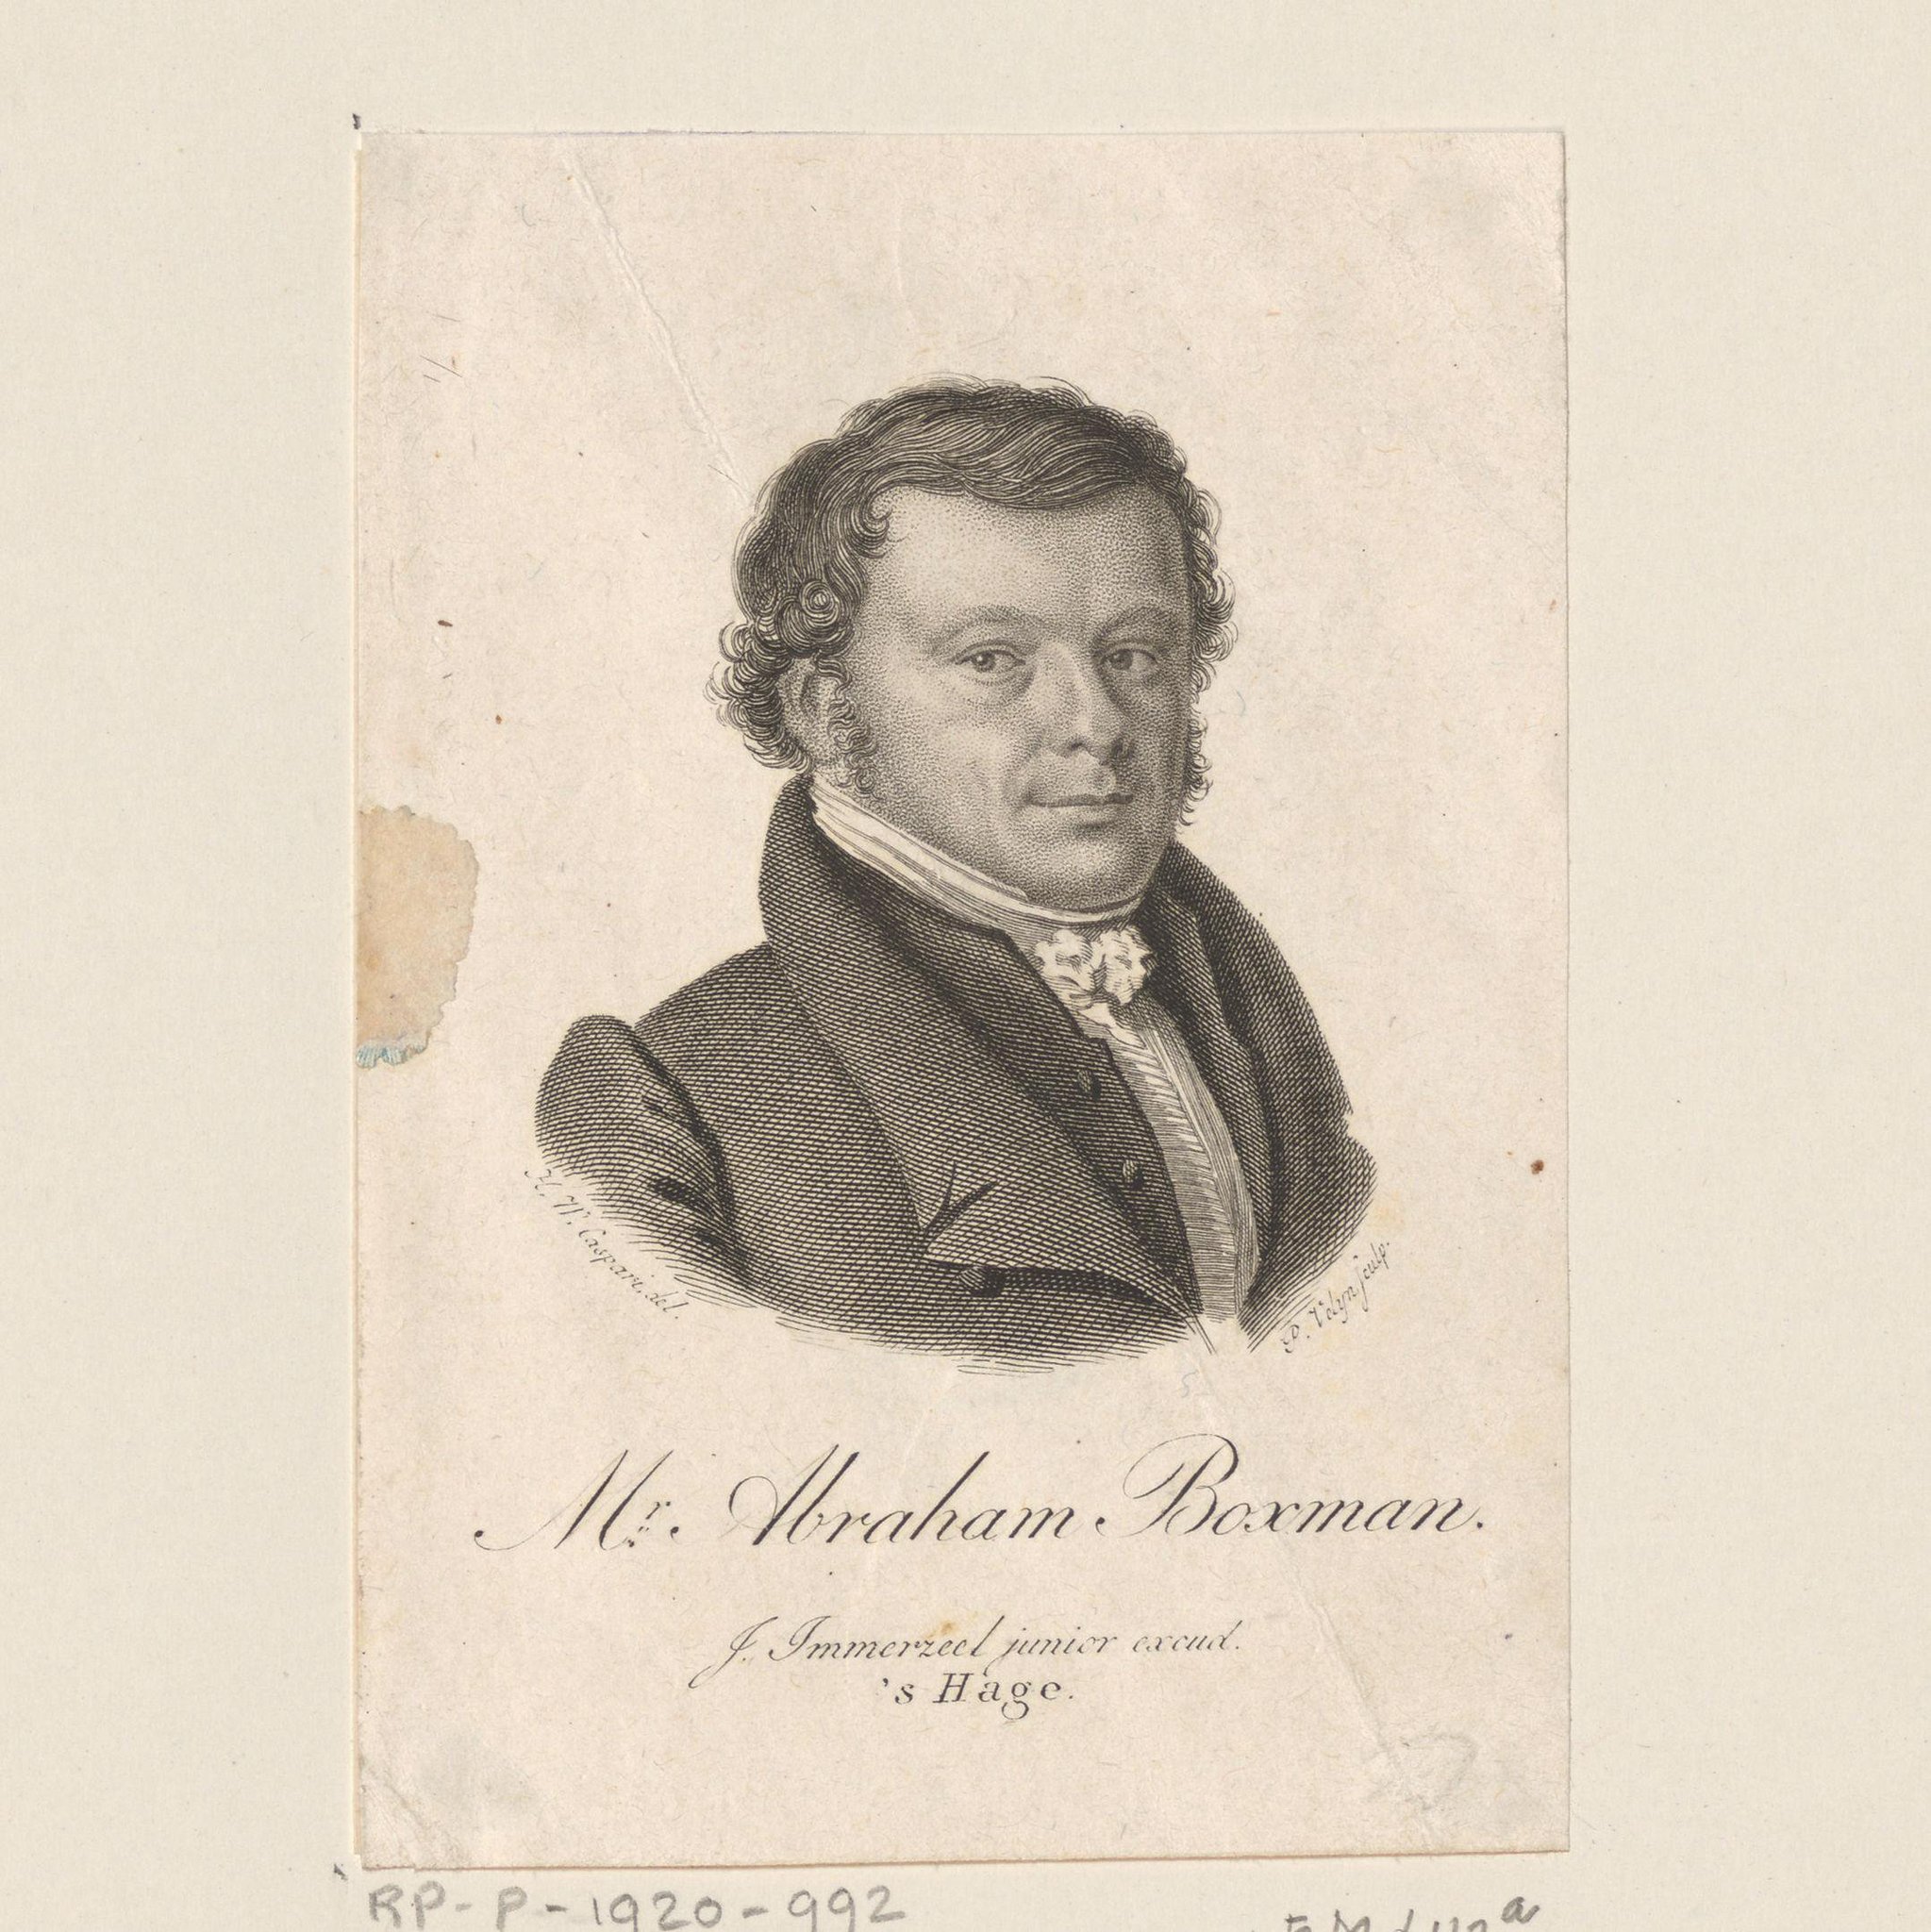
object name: print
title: Portret van Abraham Boxman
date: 1804-1832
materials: paper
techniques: engraving, etching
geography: the hague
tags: mayor, mayor, burgomaster, historical persons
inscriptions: collector's mark: Lugt 2228